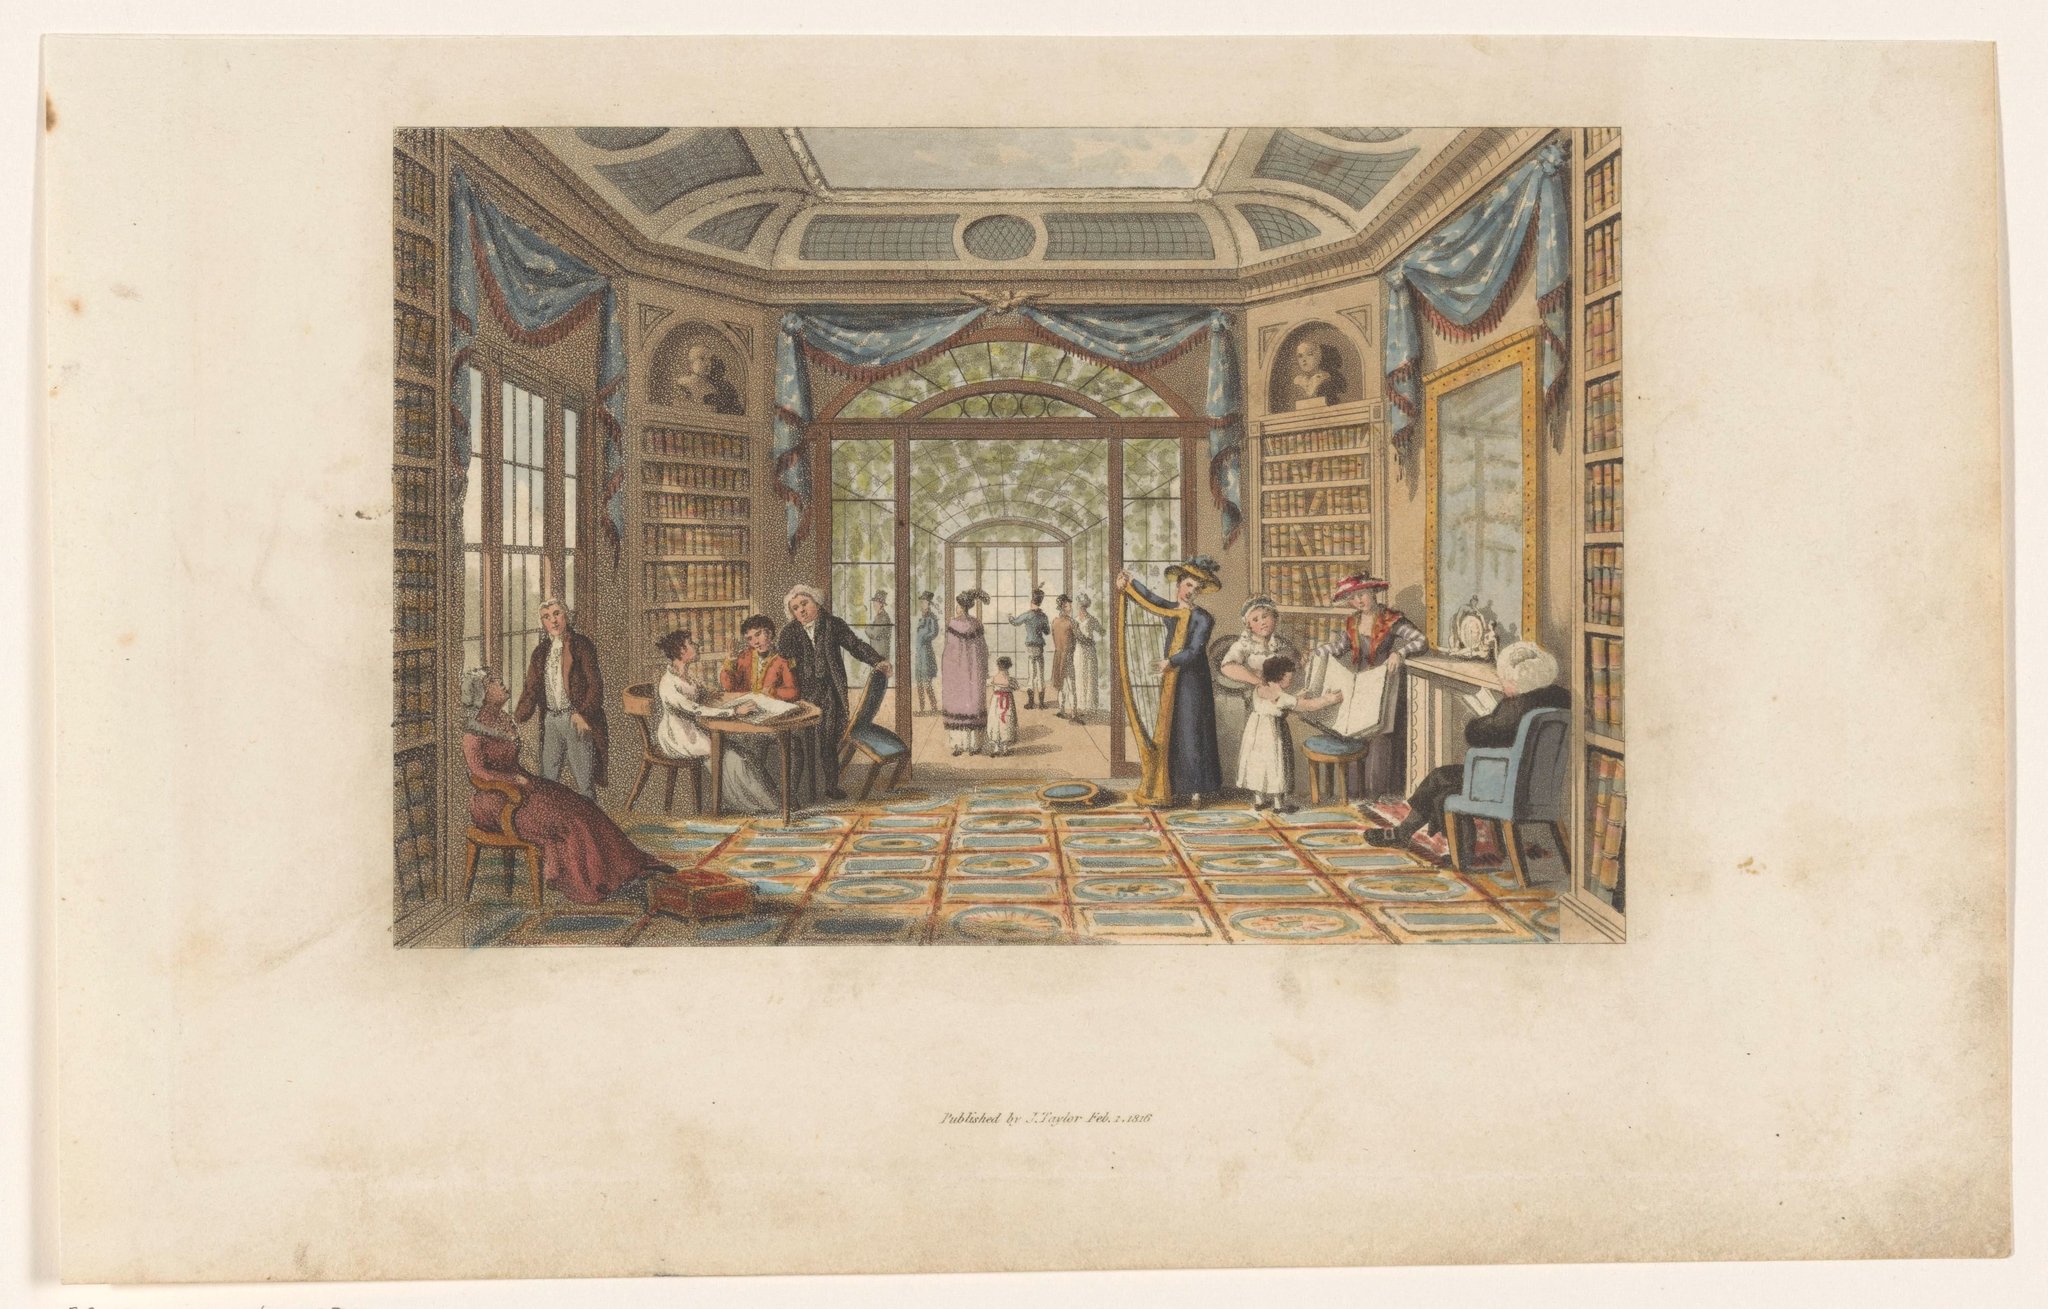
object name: book illustration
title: Gezelschap in een bibliotheek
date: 1802-1816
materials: paper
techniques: aquatint, hand coloring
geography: london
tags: bookshelves, harp, study; 'studiolo'; library, hot-house, glass-house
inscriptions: collector's mark: Lugt 4779, collector's mark: Lugt 2228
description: Prent afkomstig uit: Repton, Humphry en Repton, John Adey. Fragments on the Theory and Practice of Landscape Gardening. Londen: J. Taylor, 1816. Het blad waarop deze prent gedrukt is was oorspronkelijk groter en bevatte ook nog een prent met een illustratie van een interieur.